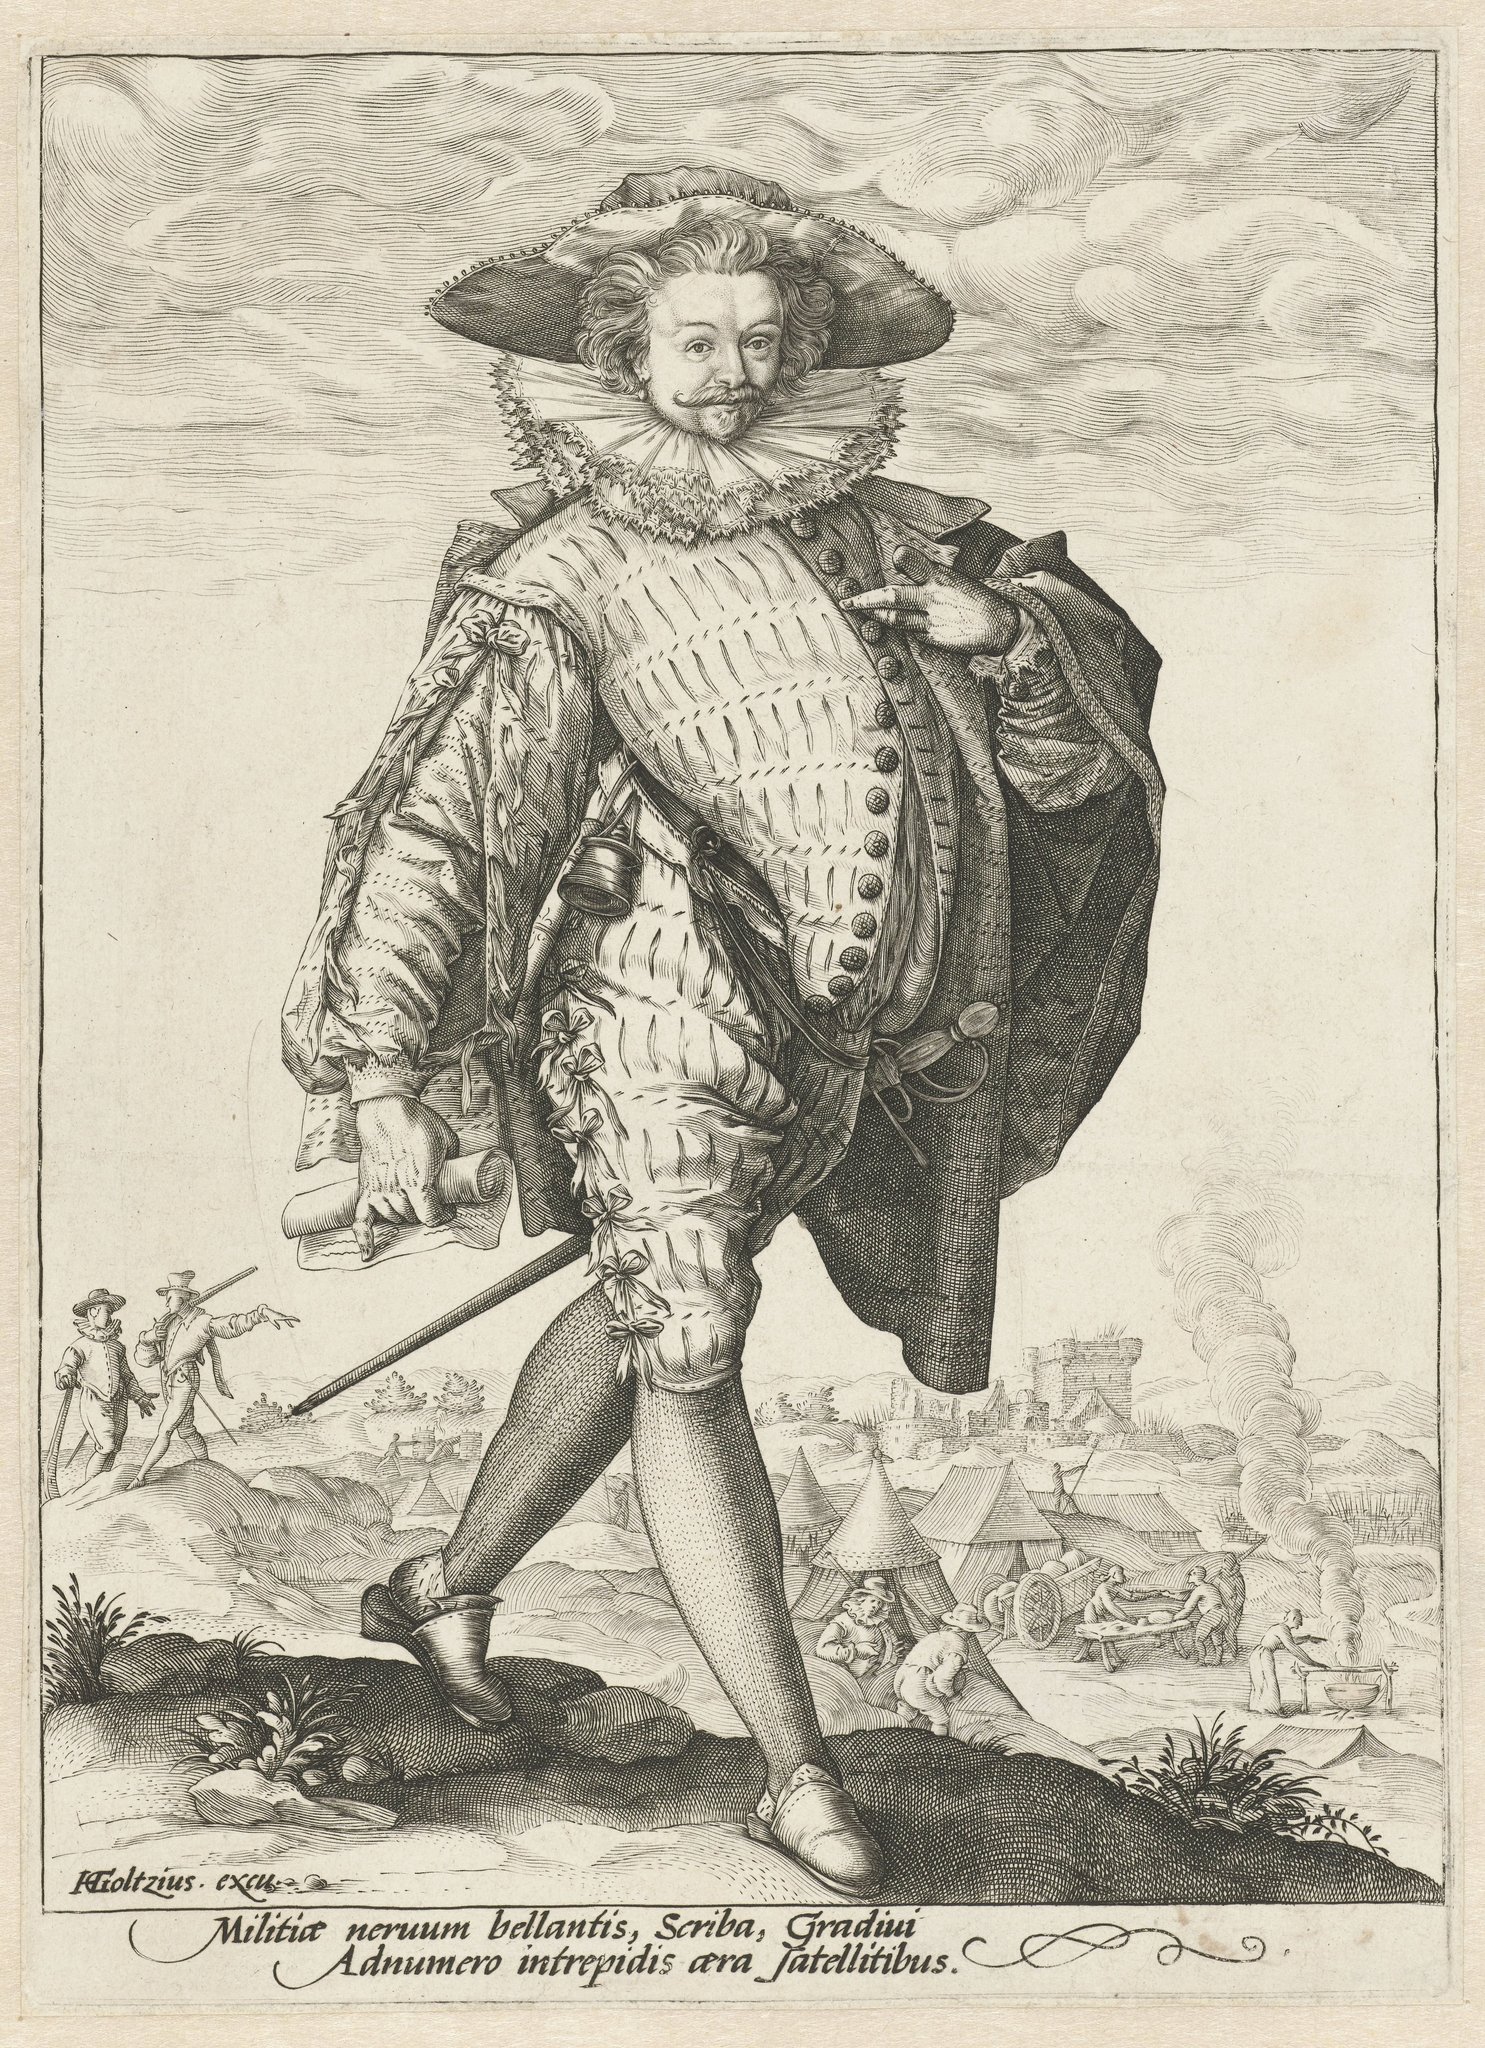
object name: print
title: Klerk in het leger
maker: hendrick goltzius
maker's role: draughtsman, painter, print maker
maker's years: 1558-1617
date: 1585-1589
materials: paper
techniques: engraving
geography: haarlem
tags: neck-gear ~ clothing (with name) (+ men's clothes), clothing for the upper part of the body (with name) (+ men's clothes), sleeves, coat (+ men's clothes), head-gear: hat (+ men's clothes), shoes, sandals (+ men's clothes), clothes, costume (+ men's clothes), shoes, sandals, trousers, breeches, etc. (breeches) (+ men's clothes), stockings, socks (+ men's clothes), sleeves (+ men's clothes), secretary, scribe, low countries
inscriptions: collector's mark: Lugt 240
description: Een deftig geklede man met een opgerold papier in de rechterhand, op trippen, ten voeten uit. Op de achtergrond een legerkamp. Onder de voorstelling twee regels tekst in Latijn. Deze prent is onderdeel van een serie van drie militaire functionarissen.